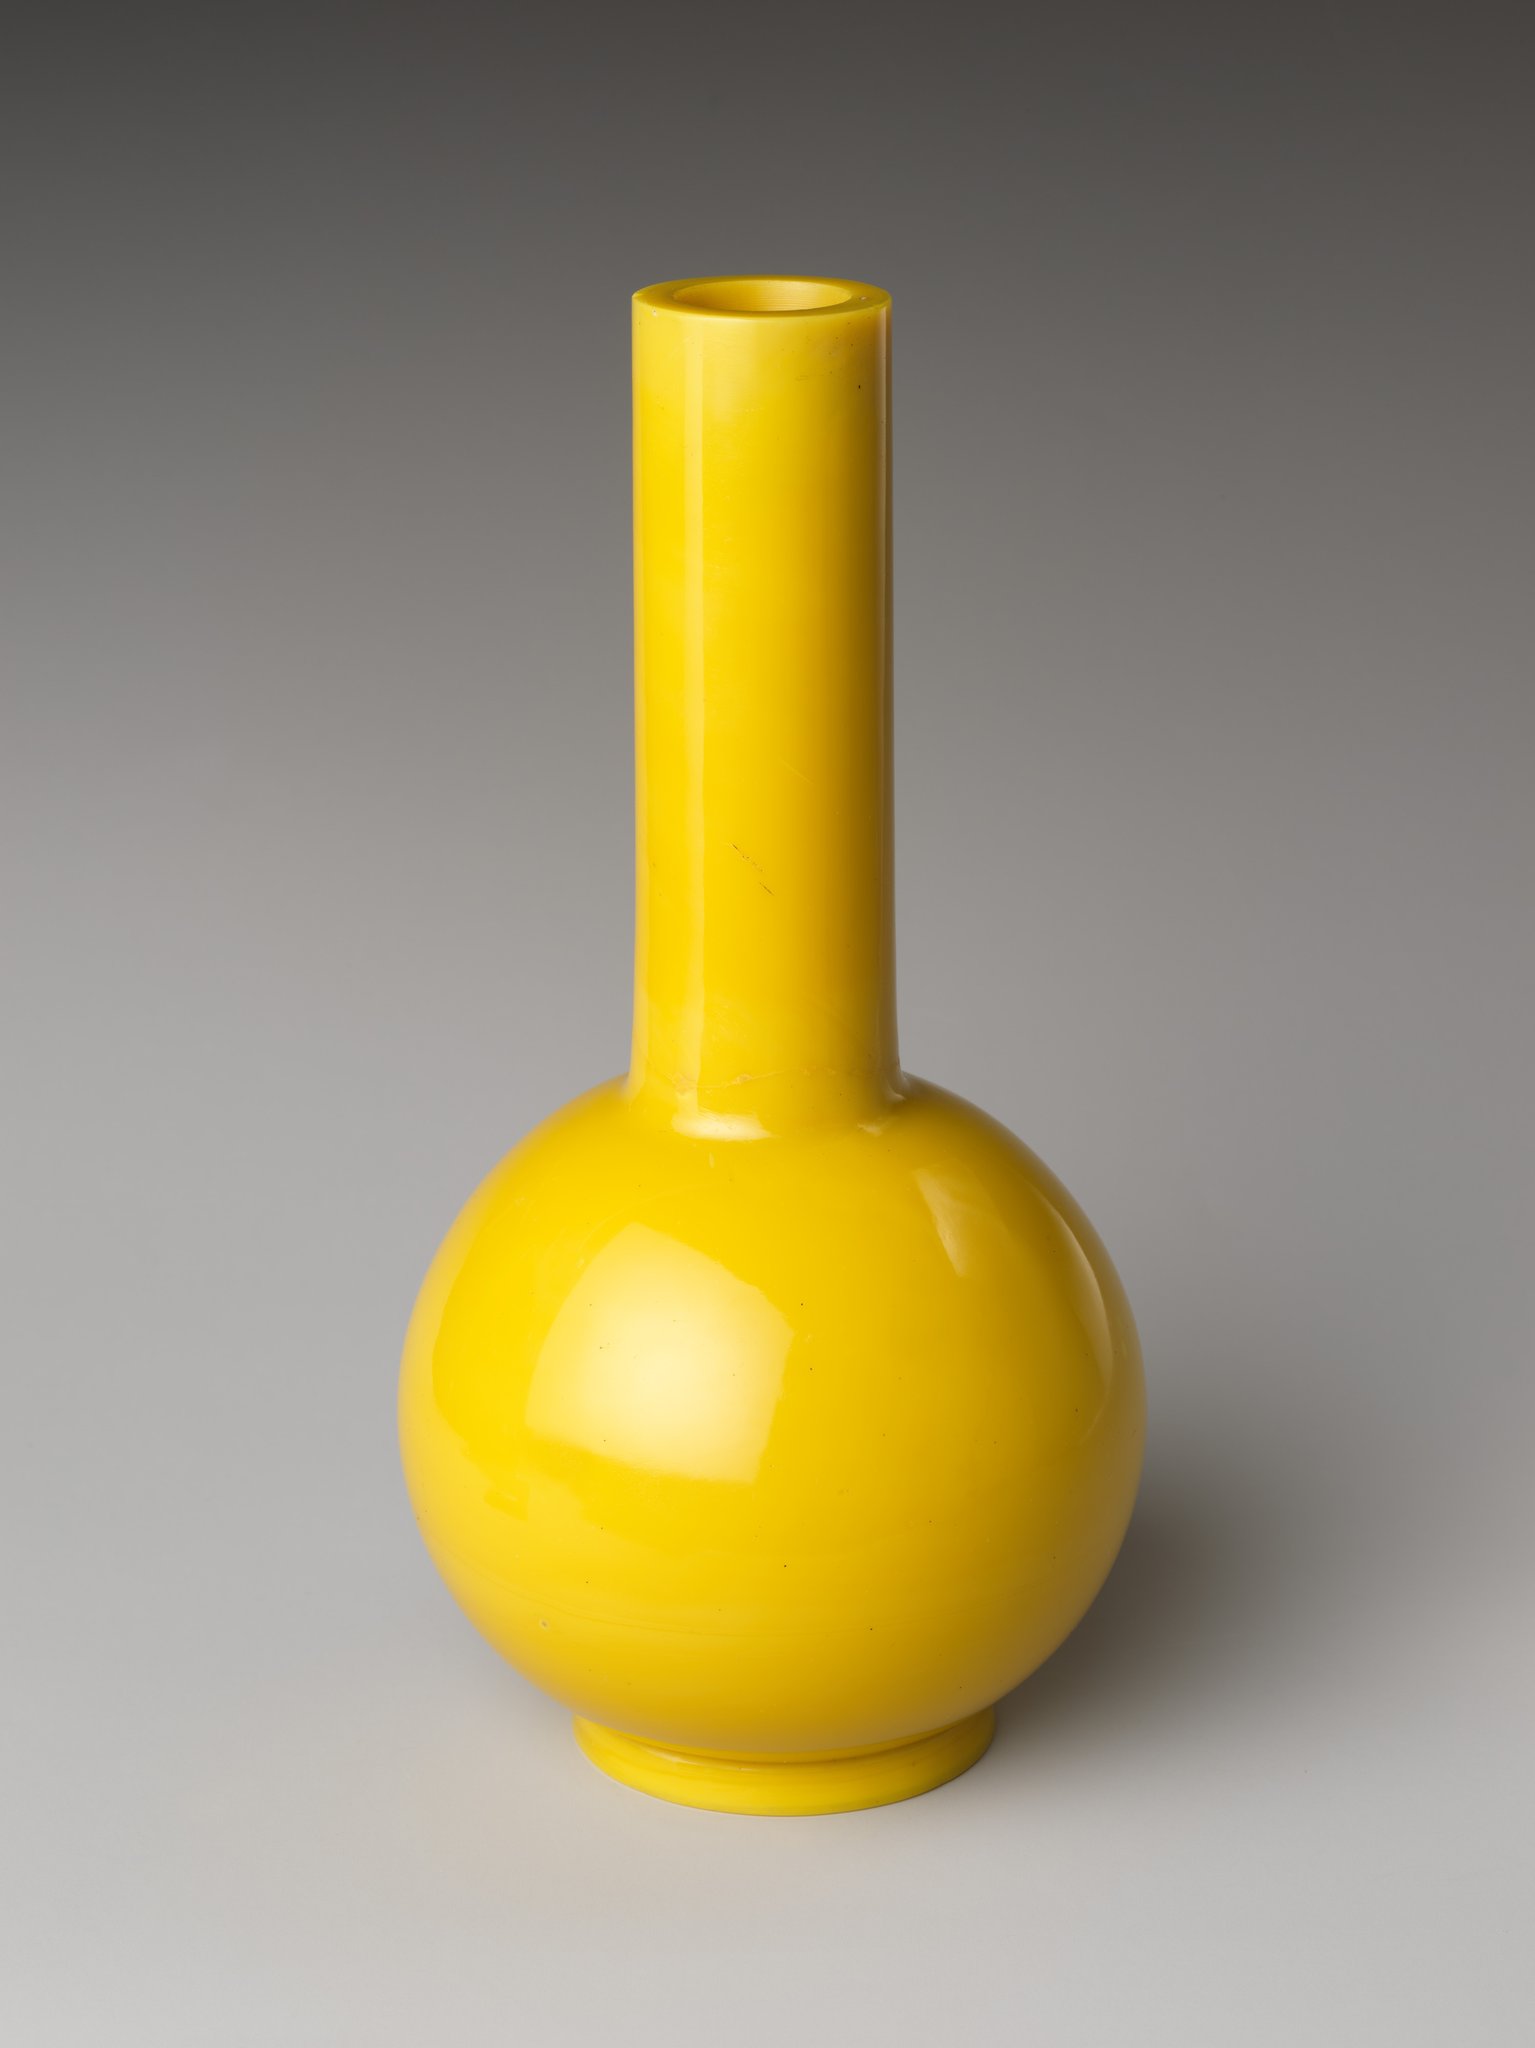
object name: vase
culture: chinese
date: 1751-1800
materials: glass